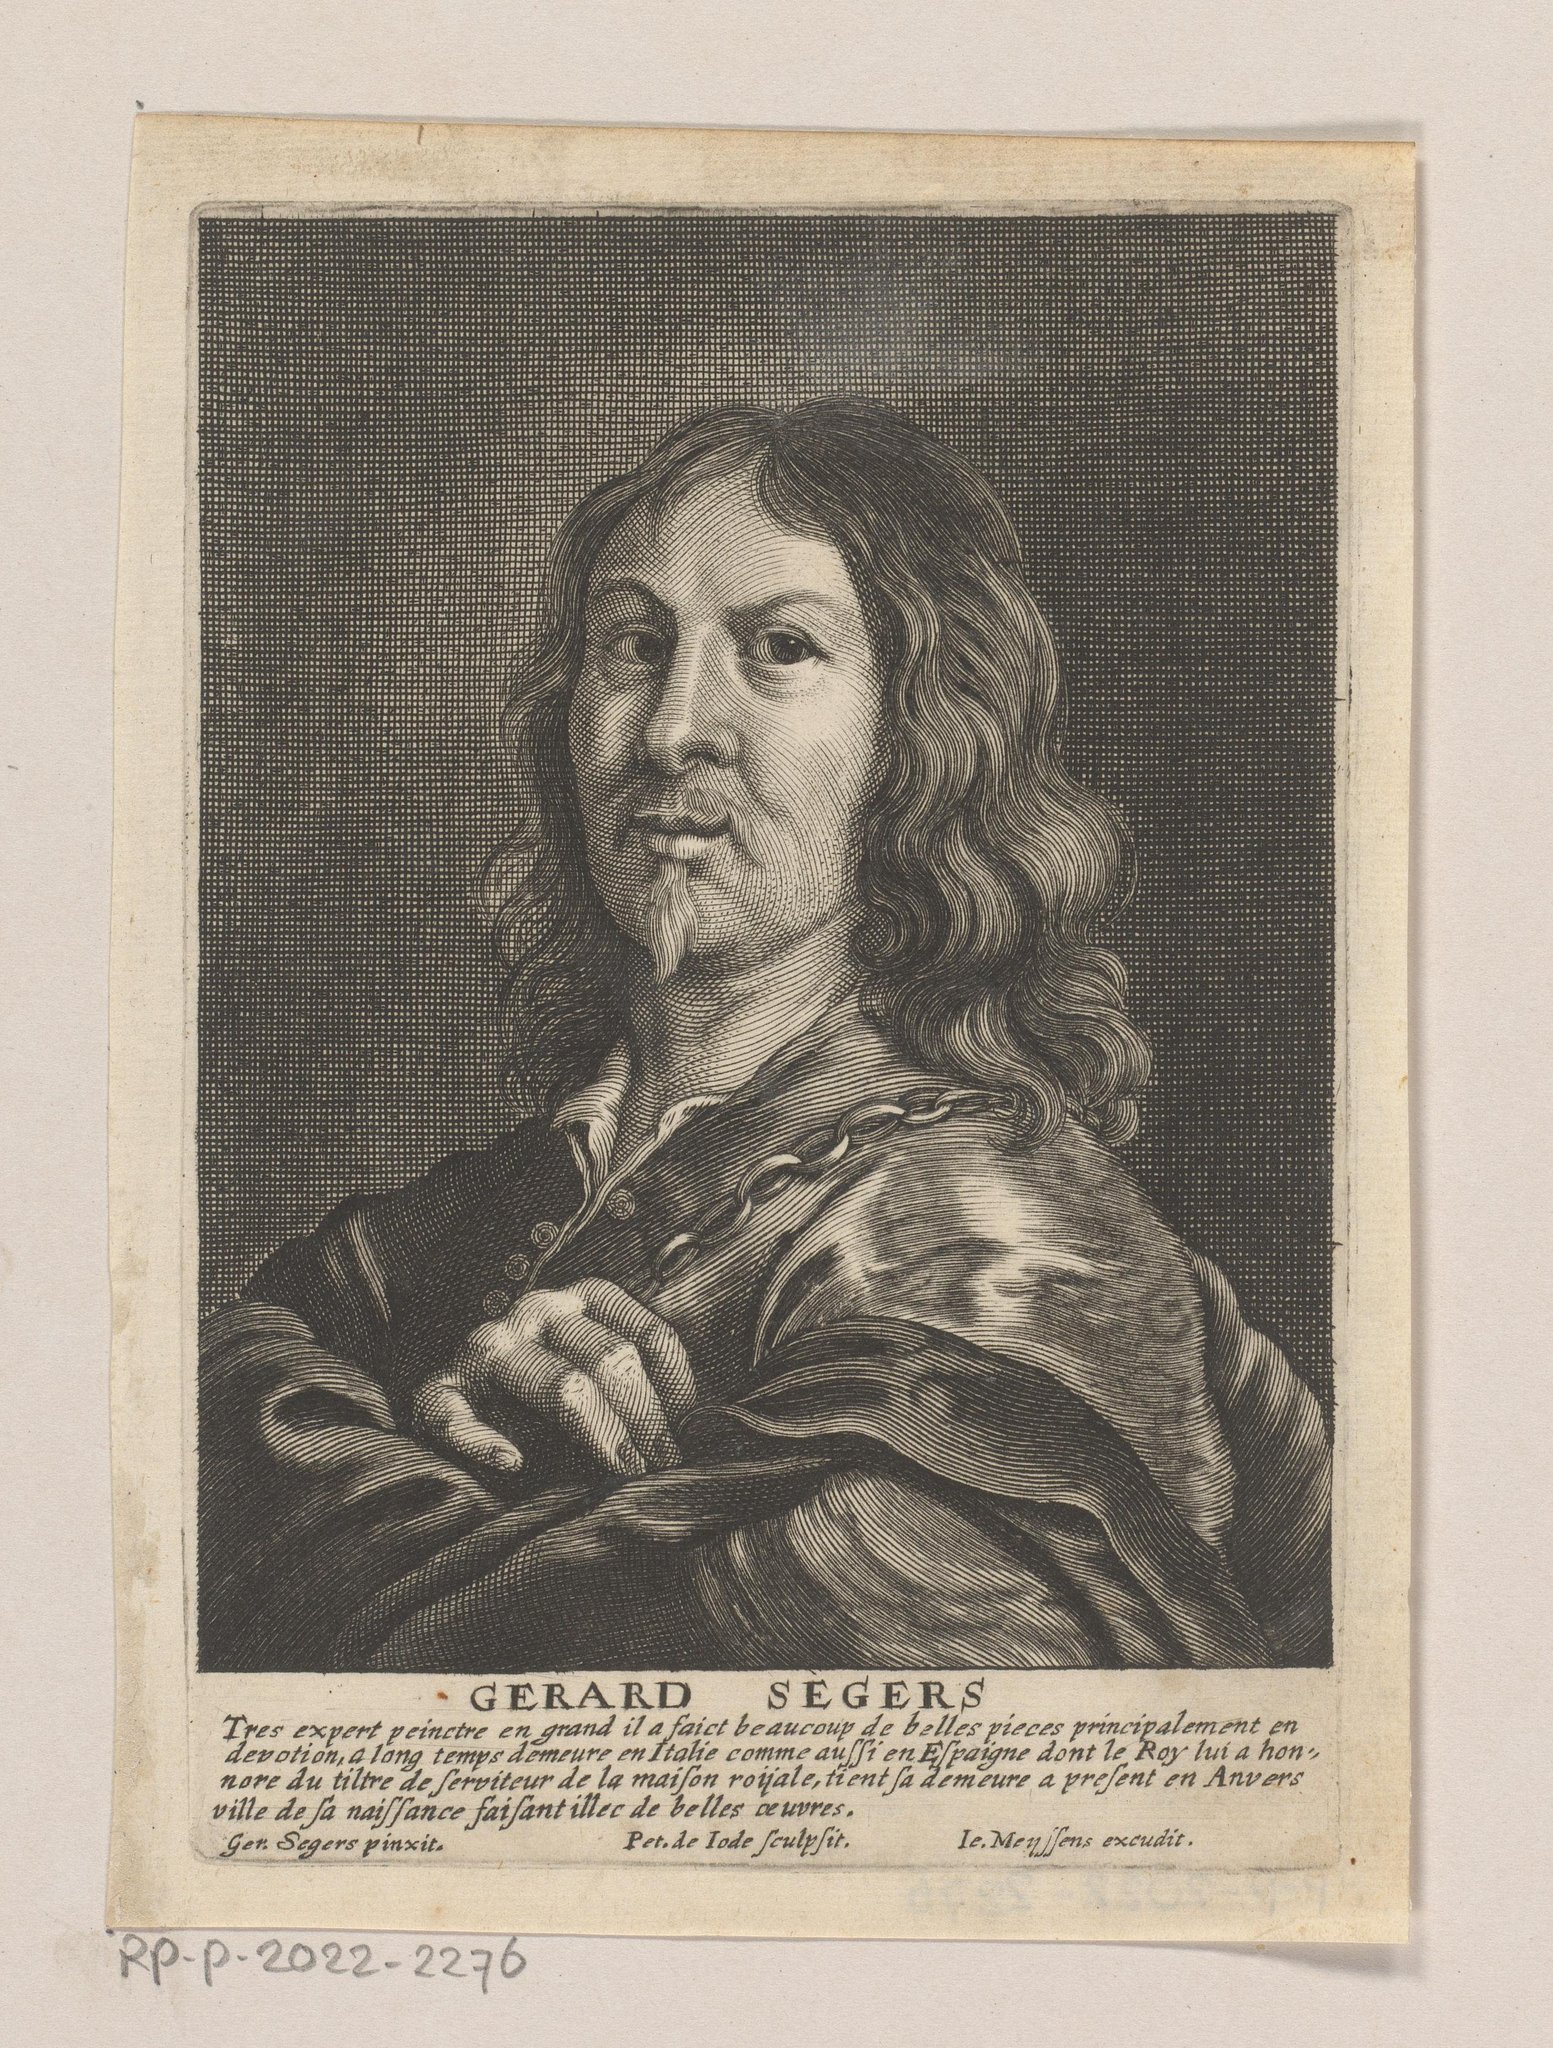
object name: print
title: Portret van Gerard Seghers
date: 1649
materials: paper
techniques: engraving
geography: antwerp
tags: antwerp, painter, print maker, gerard seghers, historical persons, portrait, self-portrait of artist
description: Prent mogelijk uit: Images de divers hommes d'esprit sublime. Antwerpen: Joannes Meyssens, 1649. Prent met tekst in boekdruk later ook gebruikt in: Bie, Cornelis de. Het gulden Cabinet vande edel vry schilder const (...). Antwerpen: Joannes Meyssens, 1661.